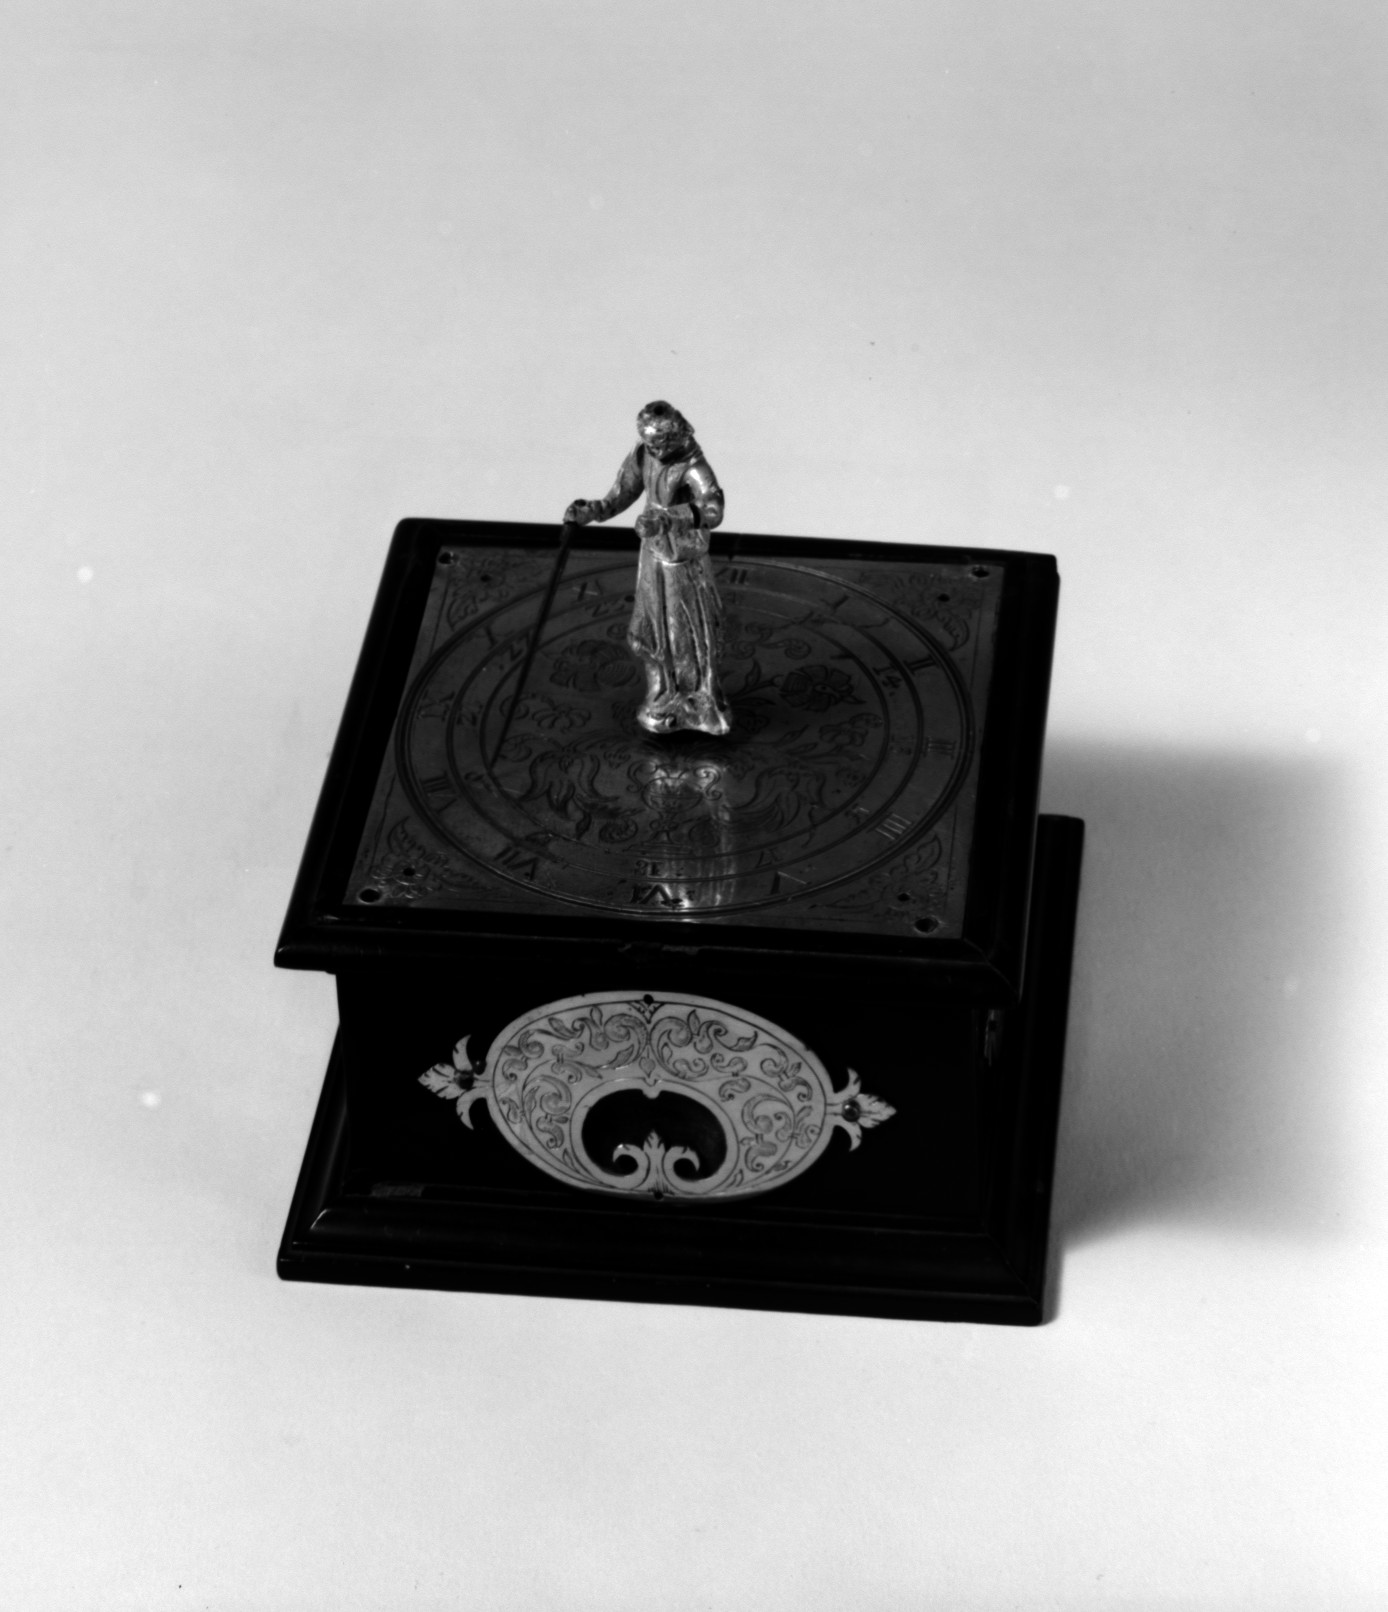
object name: clock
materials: brass, wood, gilt brass, iron, steel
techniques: veneering